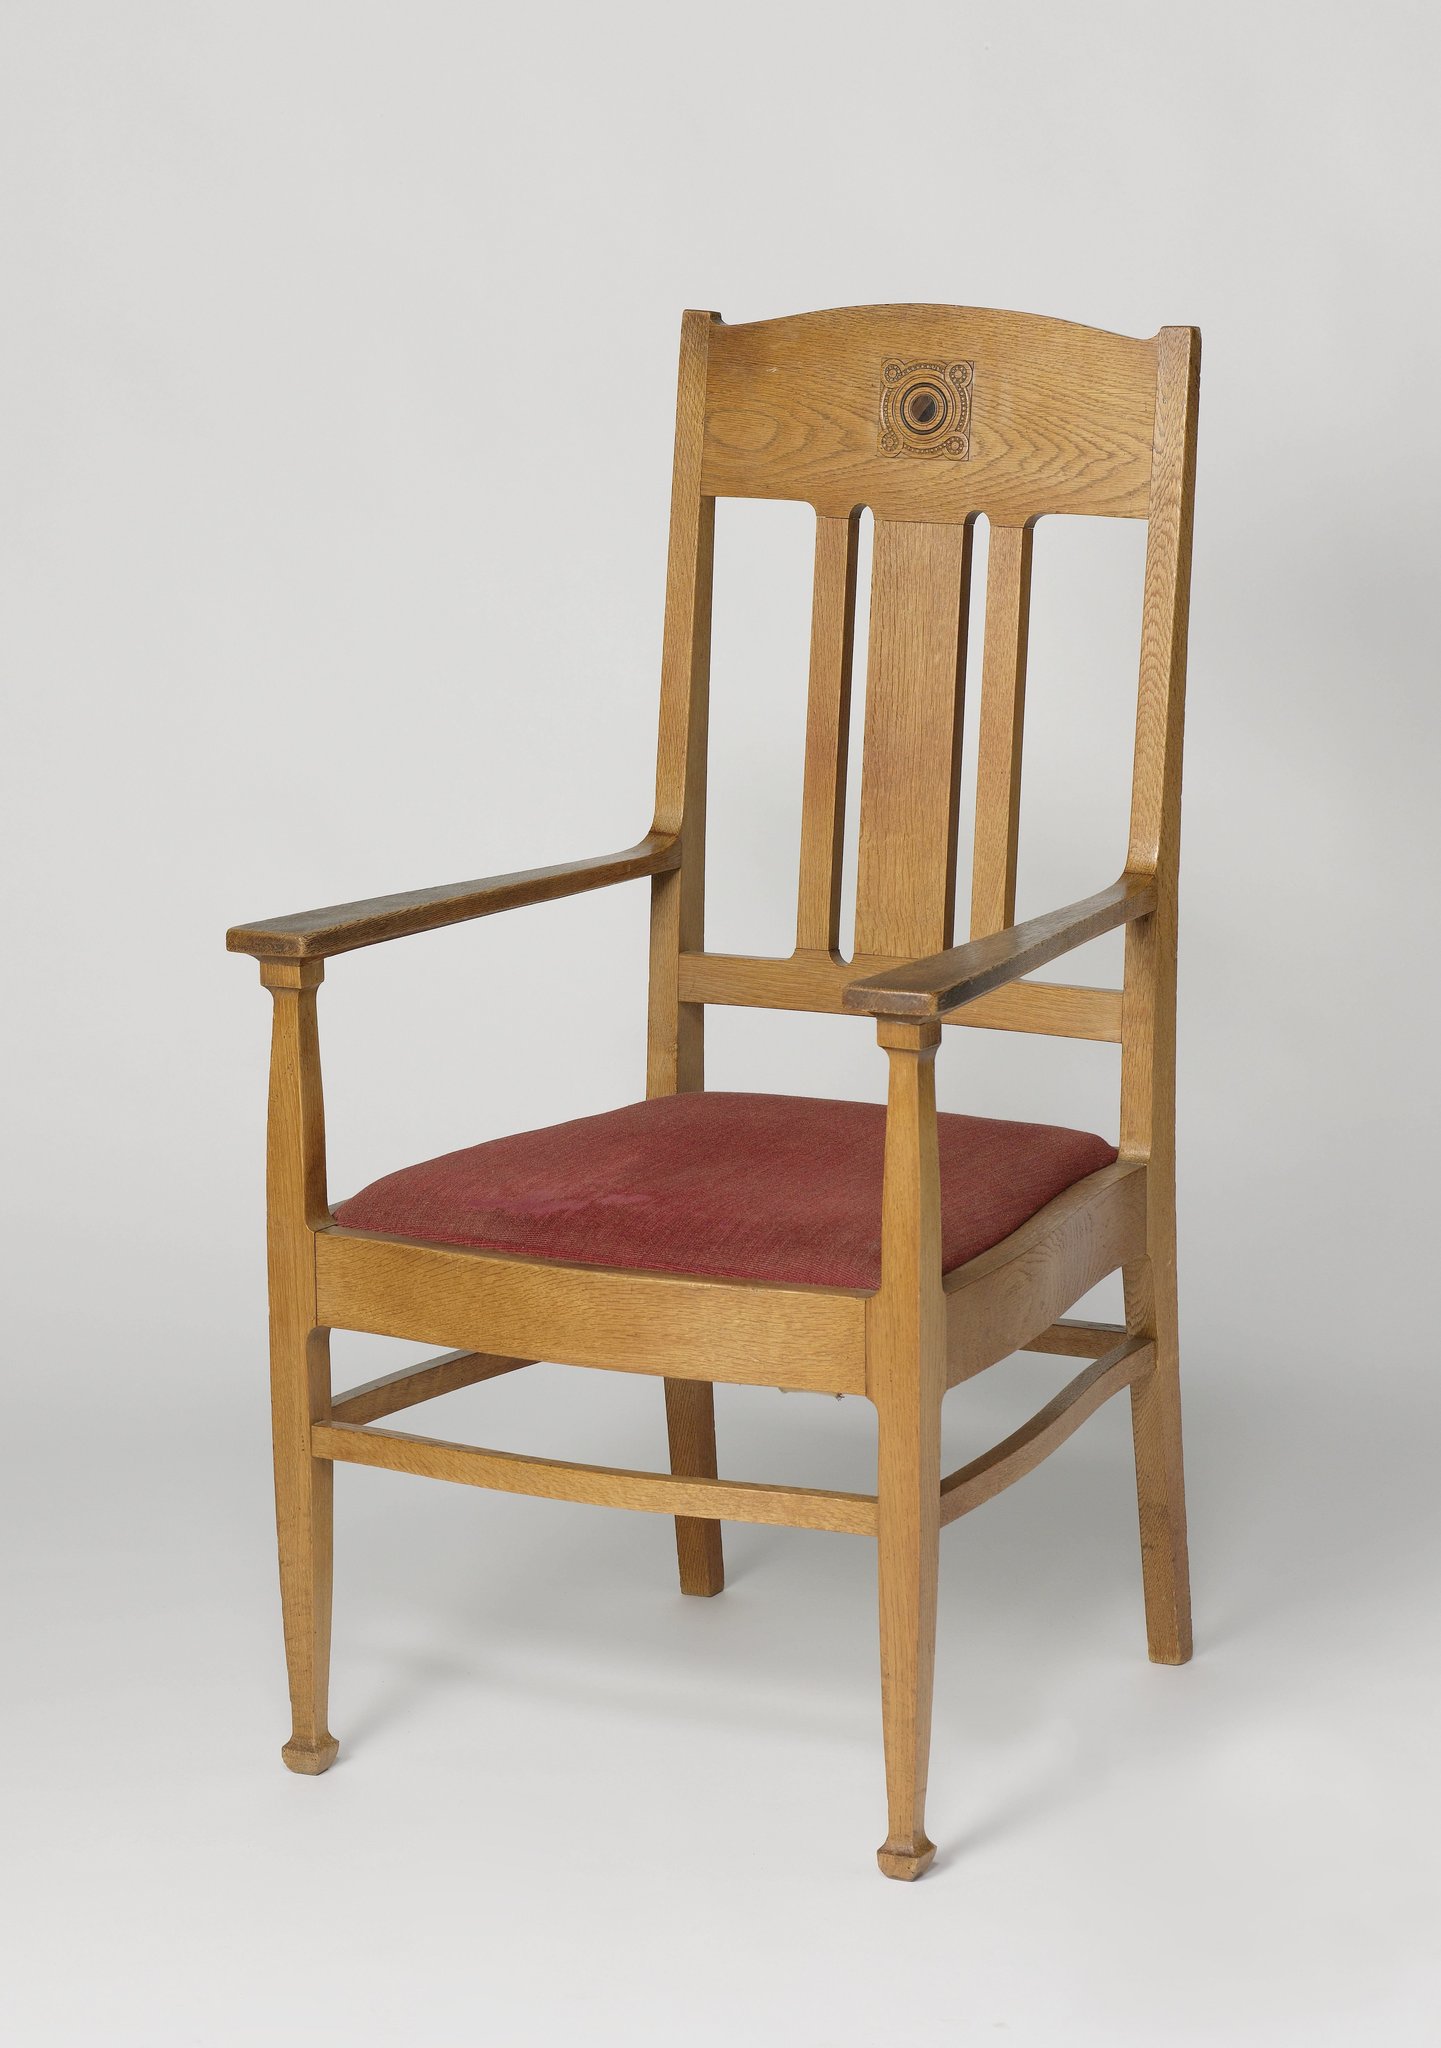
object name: seating furniture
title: Armstoel met een gesneden gevlochten rozet en bekleed met rood/roze trijp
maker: karel petrus cornelis de bazel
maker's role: draughtsman, print maker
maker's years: 1869-1923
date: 1894-1900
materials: wood, wool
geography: netherlands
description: Armstoel van eikenhout rustend op vier gebogen poten. De poten zijn onderling verbonden door middel van gebogen regels. De voorpoten lopen door in de stutten voor de armleggers. De achterpoten lopen door in de rugstijlen. De rugleuning bestaat uit een paneel met geronde bovenkant aan de bovenzijde en een regel aan de onderzijde met daartussen drie stijlen waarvan de middelste stijl breder is dan de twee overigen. Op het paneel aan de bovenzijde is in het midden een gesneden gevlochten rozet met parelranden en ingelegd met ebbenhout. De armleggers verbreden naar de voorkant. De zitting is trapeziumvormig en is bekleed met rood/roze trijp.